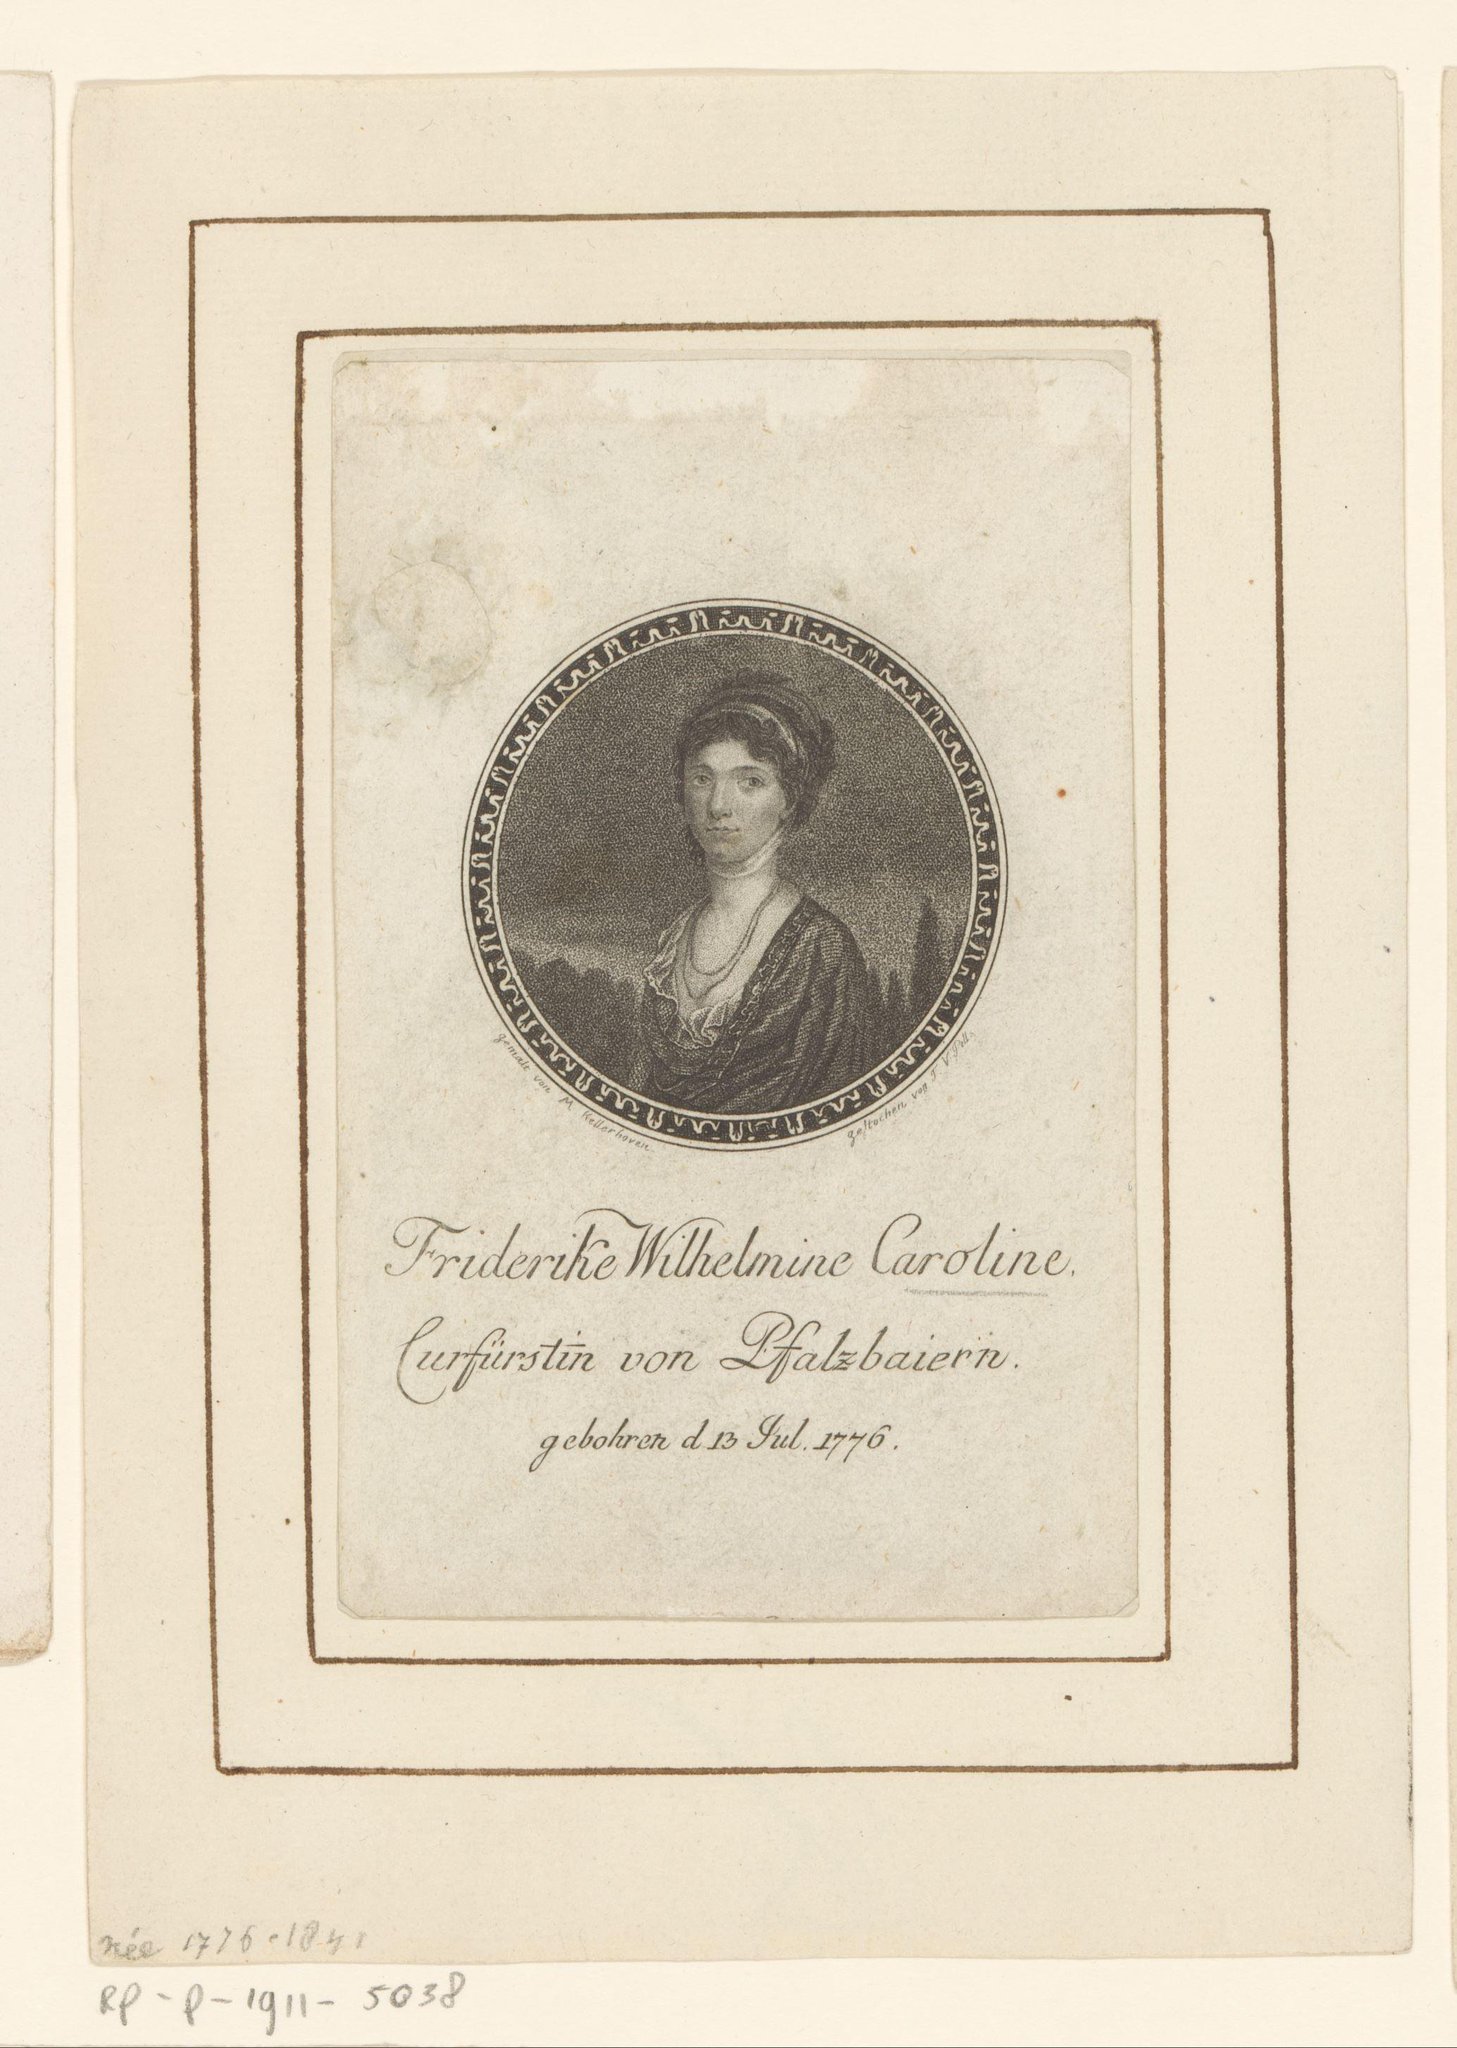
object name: print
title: Portret van Caroline van Baden, koningin van Beieren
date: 1803-1880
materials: paper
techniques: engraving, etching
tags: historical persons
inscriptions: collector's mark: Lugt 2228